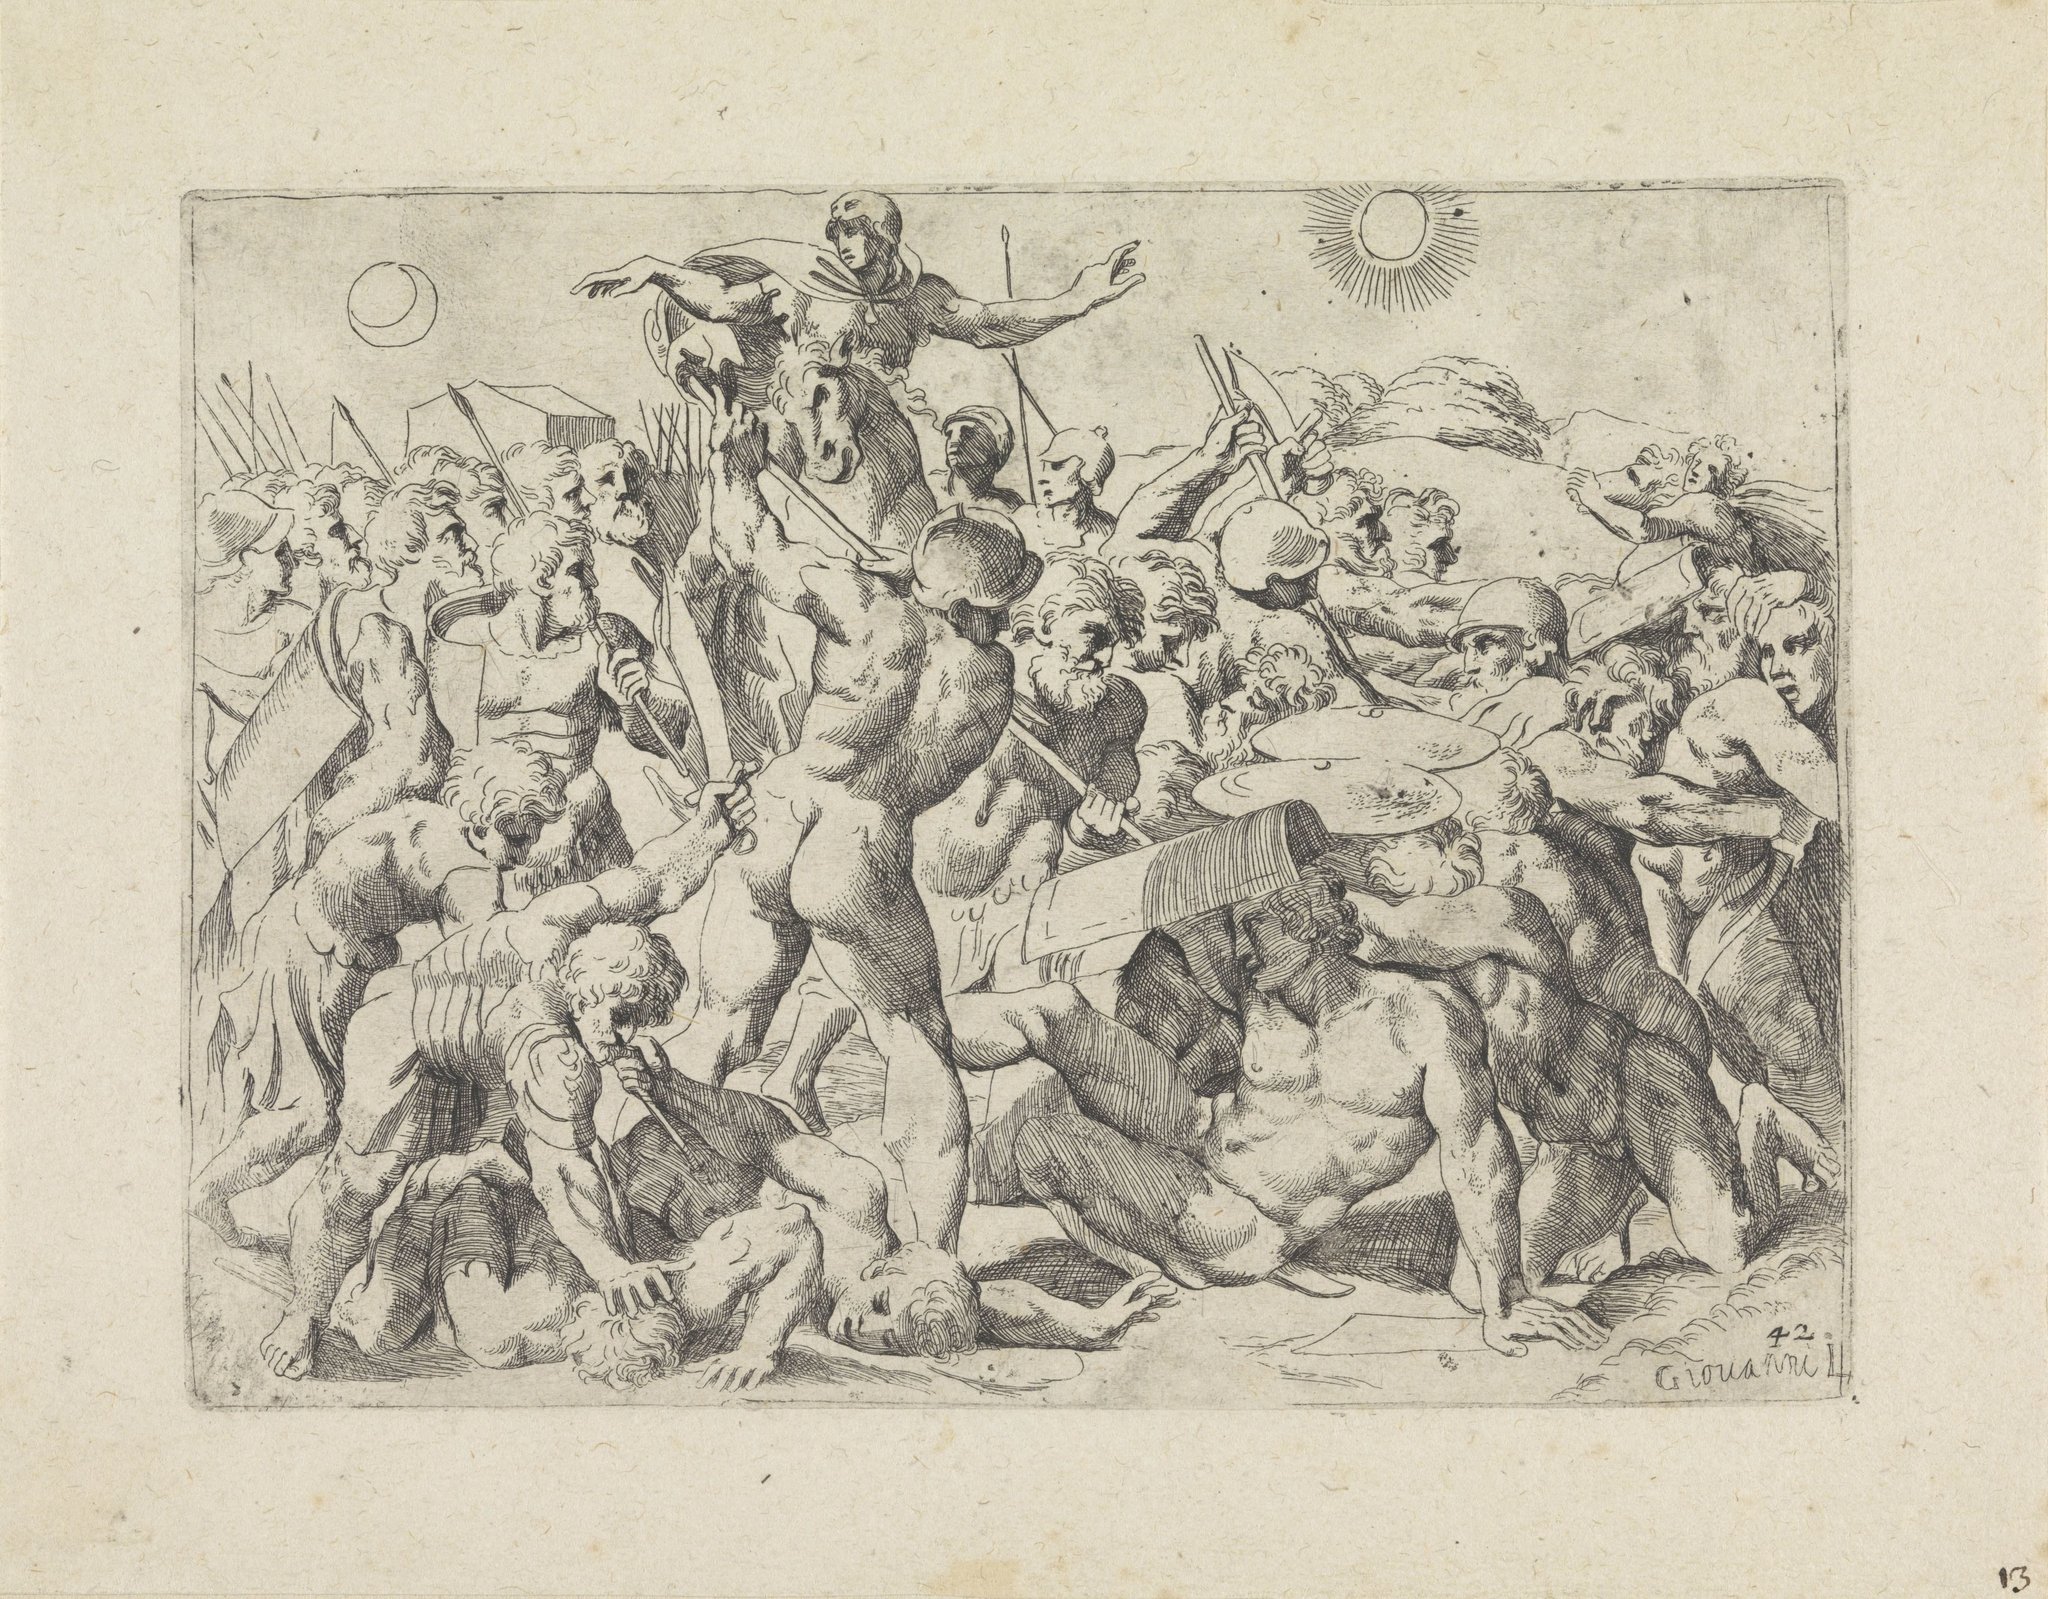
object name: print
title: Jozua beveelt de zon en de maan stil te staan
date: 1607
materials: paper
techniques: etching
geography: italy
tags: ark of the covenant ~ jewish religion, joshua orders the sun and the moon to stand still over gibeon and aijalon until the amorites who had besieged the city of gibeon are routed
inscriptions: collector's mark: ‘Hinloopen’, number: ‘13’, collector's mark: Lugt 11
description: Op de voorgrond een kluwen van strijdende Amorieten en Israëlieten. Jozua zit te paard en laat de zon en de maan stil staan. Op de achtergrond links wordt de Ark des Verbonds gedragen.